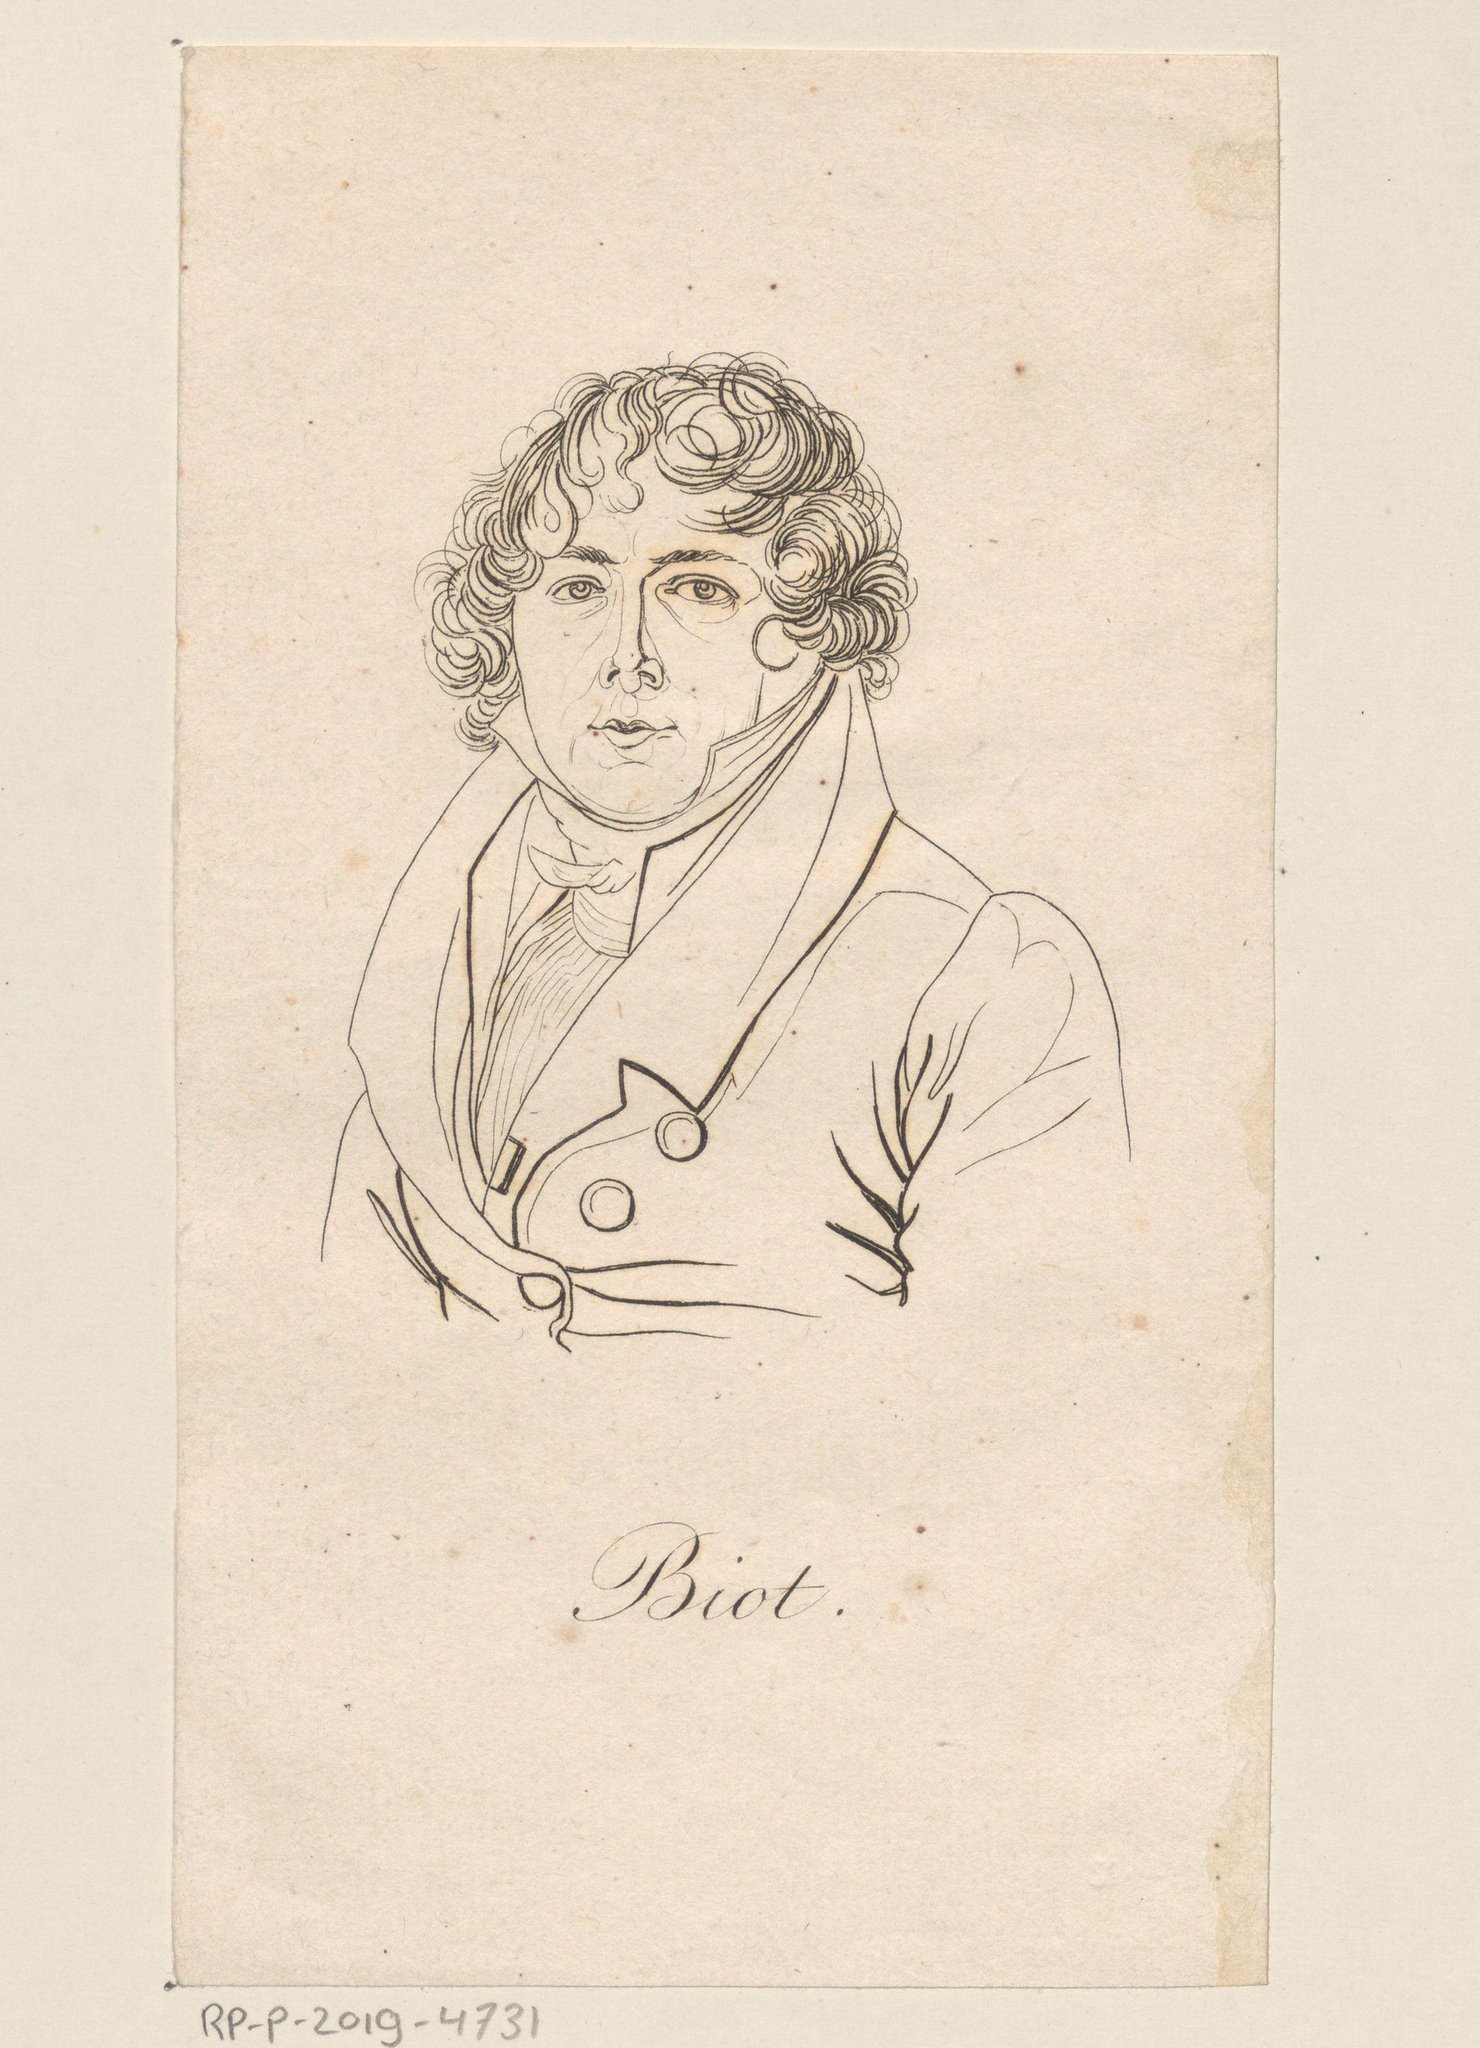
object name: print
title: Portret van Jean-Baptiste Biot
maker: Anonymous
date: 1800-1849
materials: paper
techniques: etching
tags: paris, physicist, historical persons